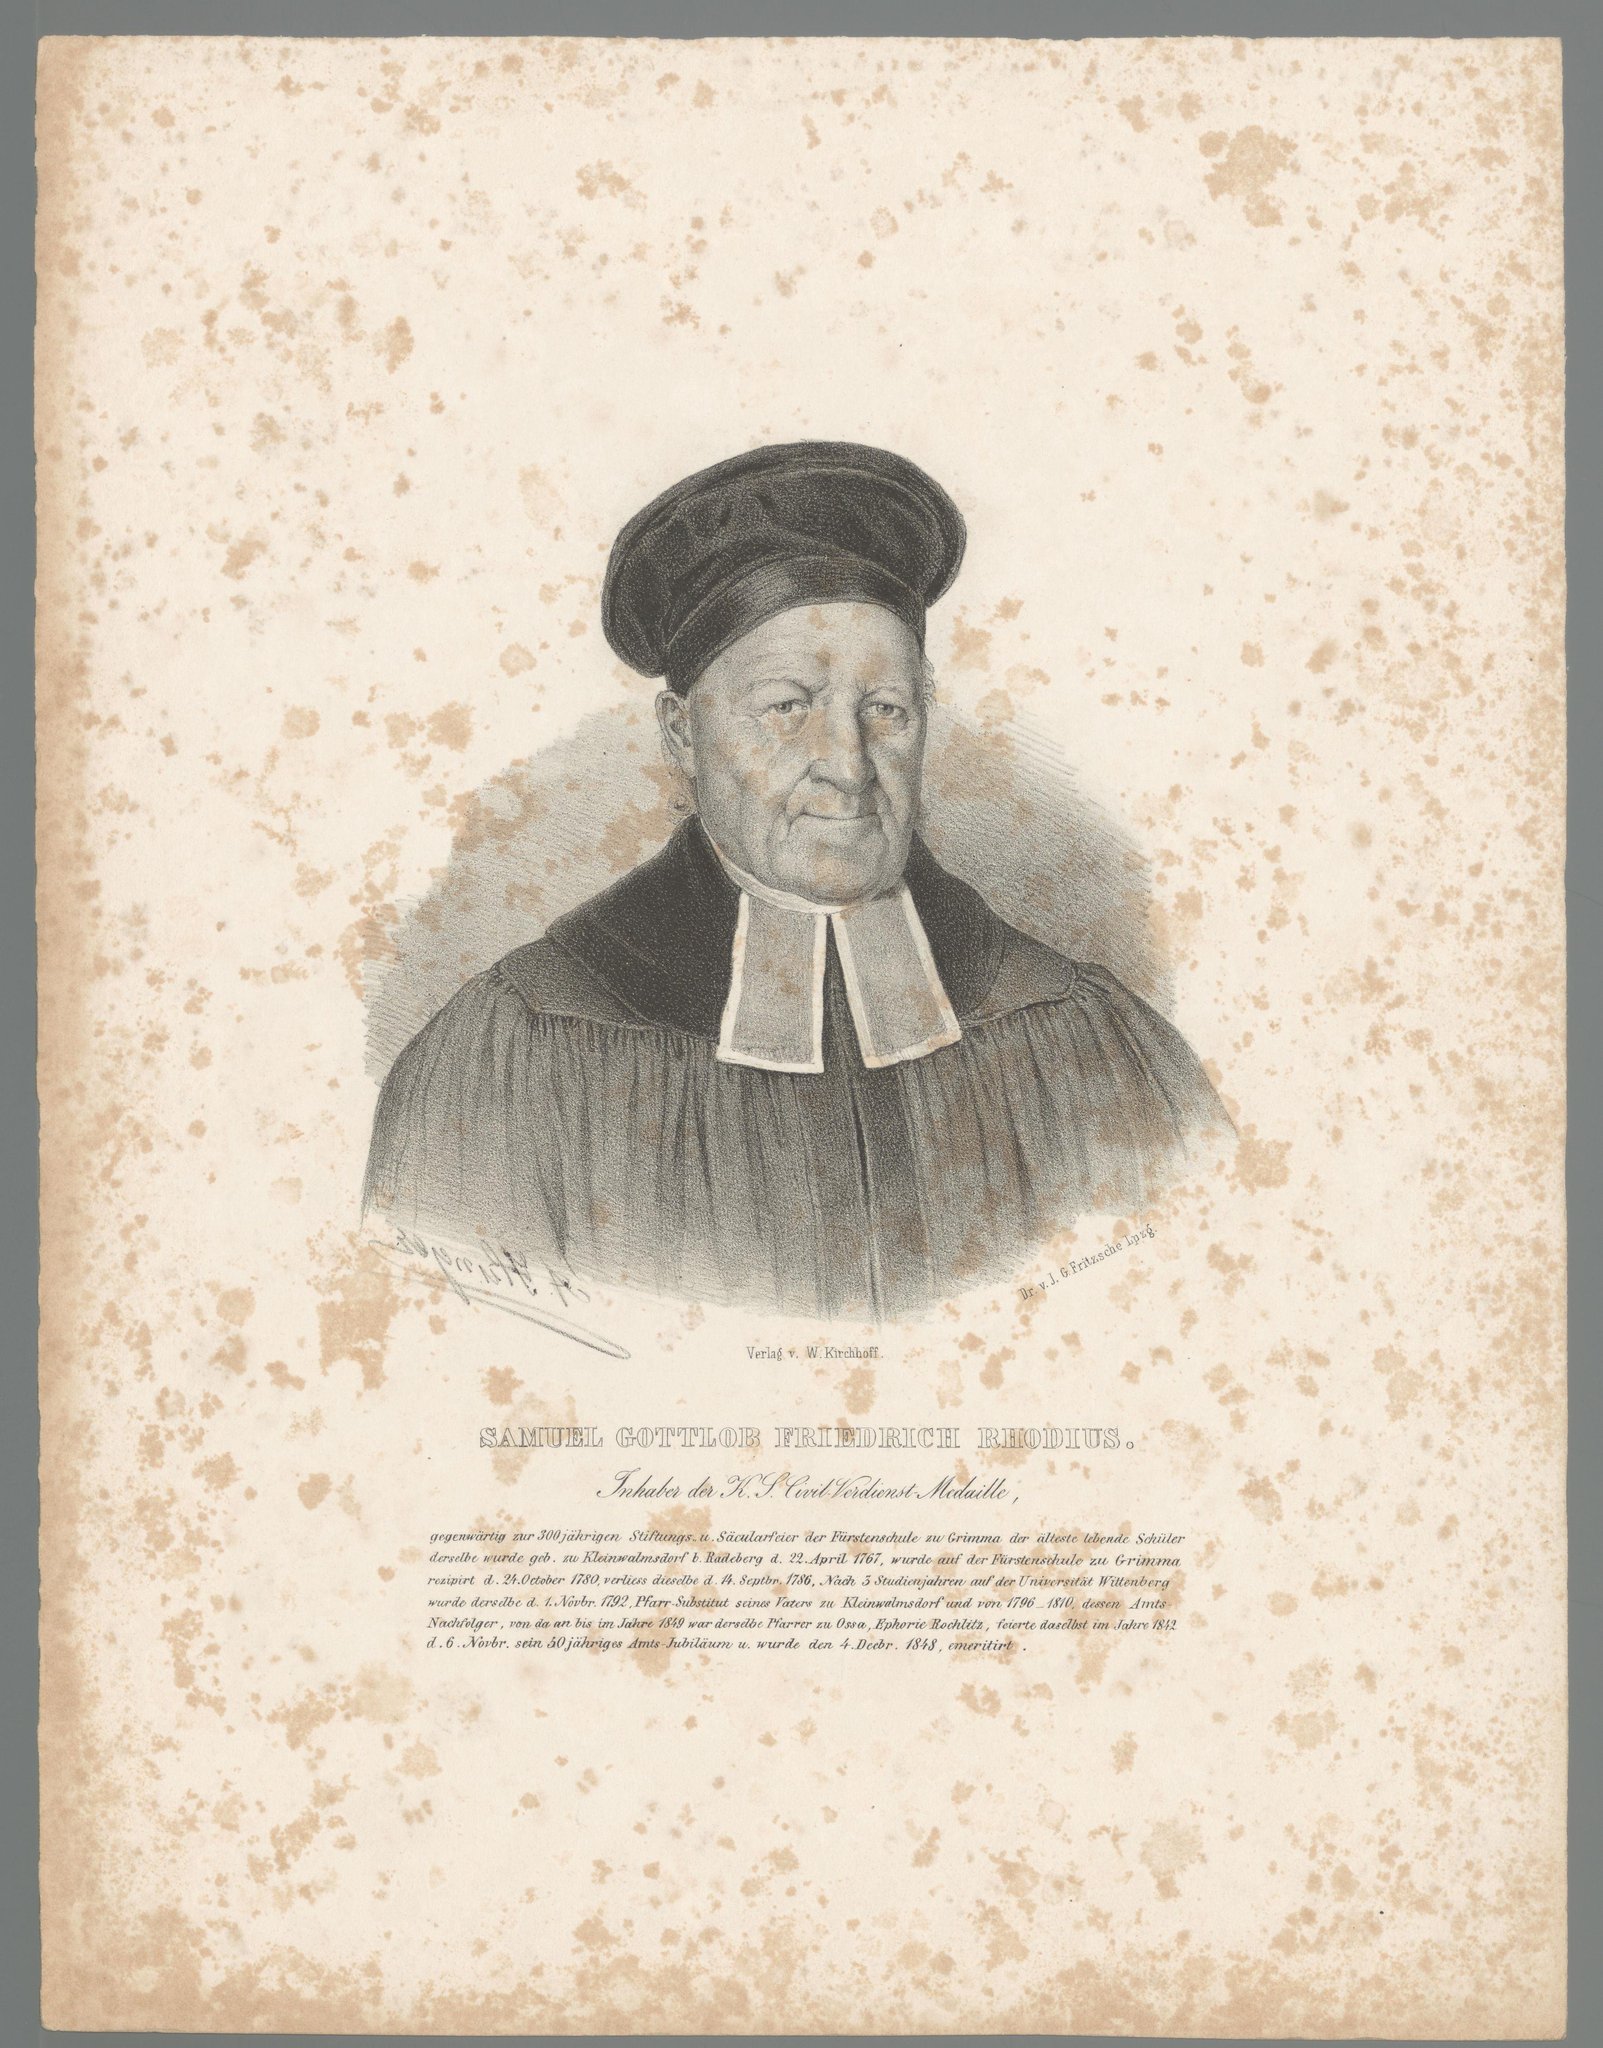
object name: print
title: Portret van Samuel Gottlob Friedrich Rhodius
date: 1848-1855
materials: paper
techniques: lithograph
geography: leipzig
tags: head-gear, adult man, historical persons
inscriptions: collector's mark: Lugt 2228